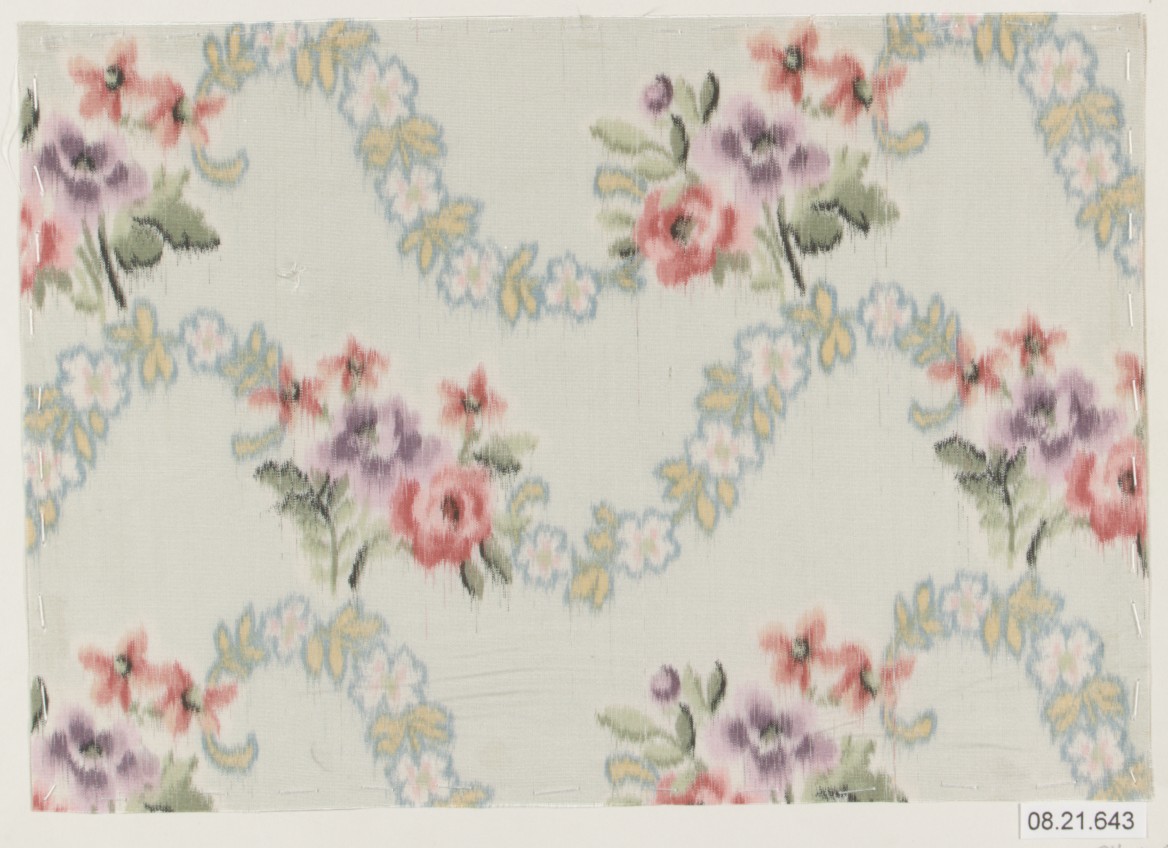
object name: textile sample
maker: Anonymous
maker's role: designer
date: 1900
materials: silk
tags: flowers